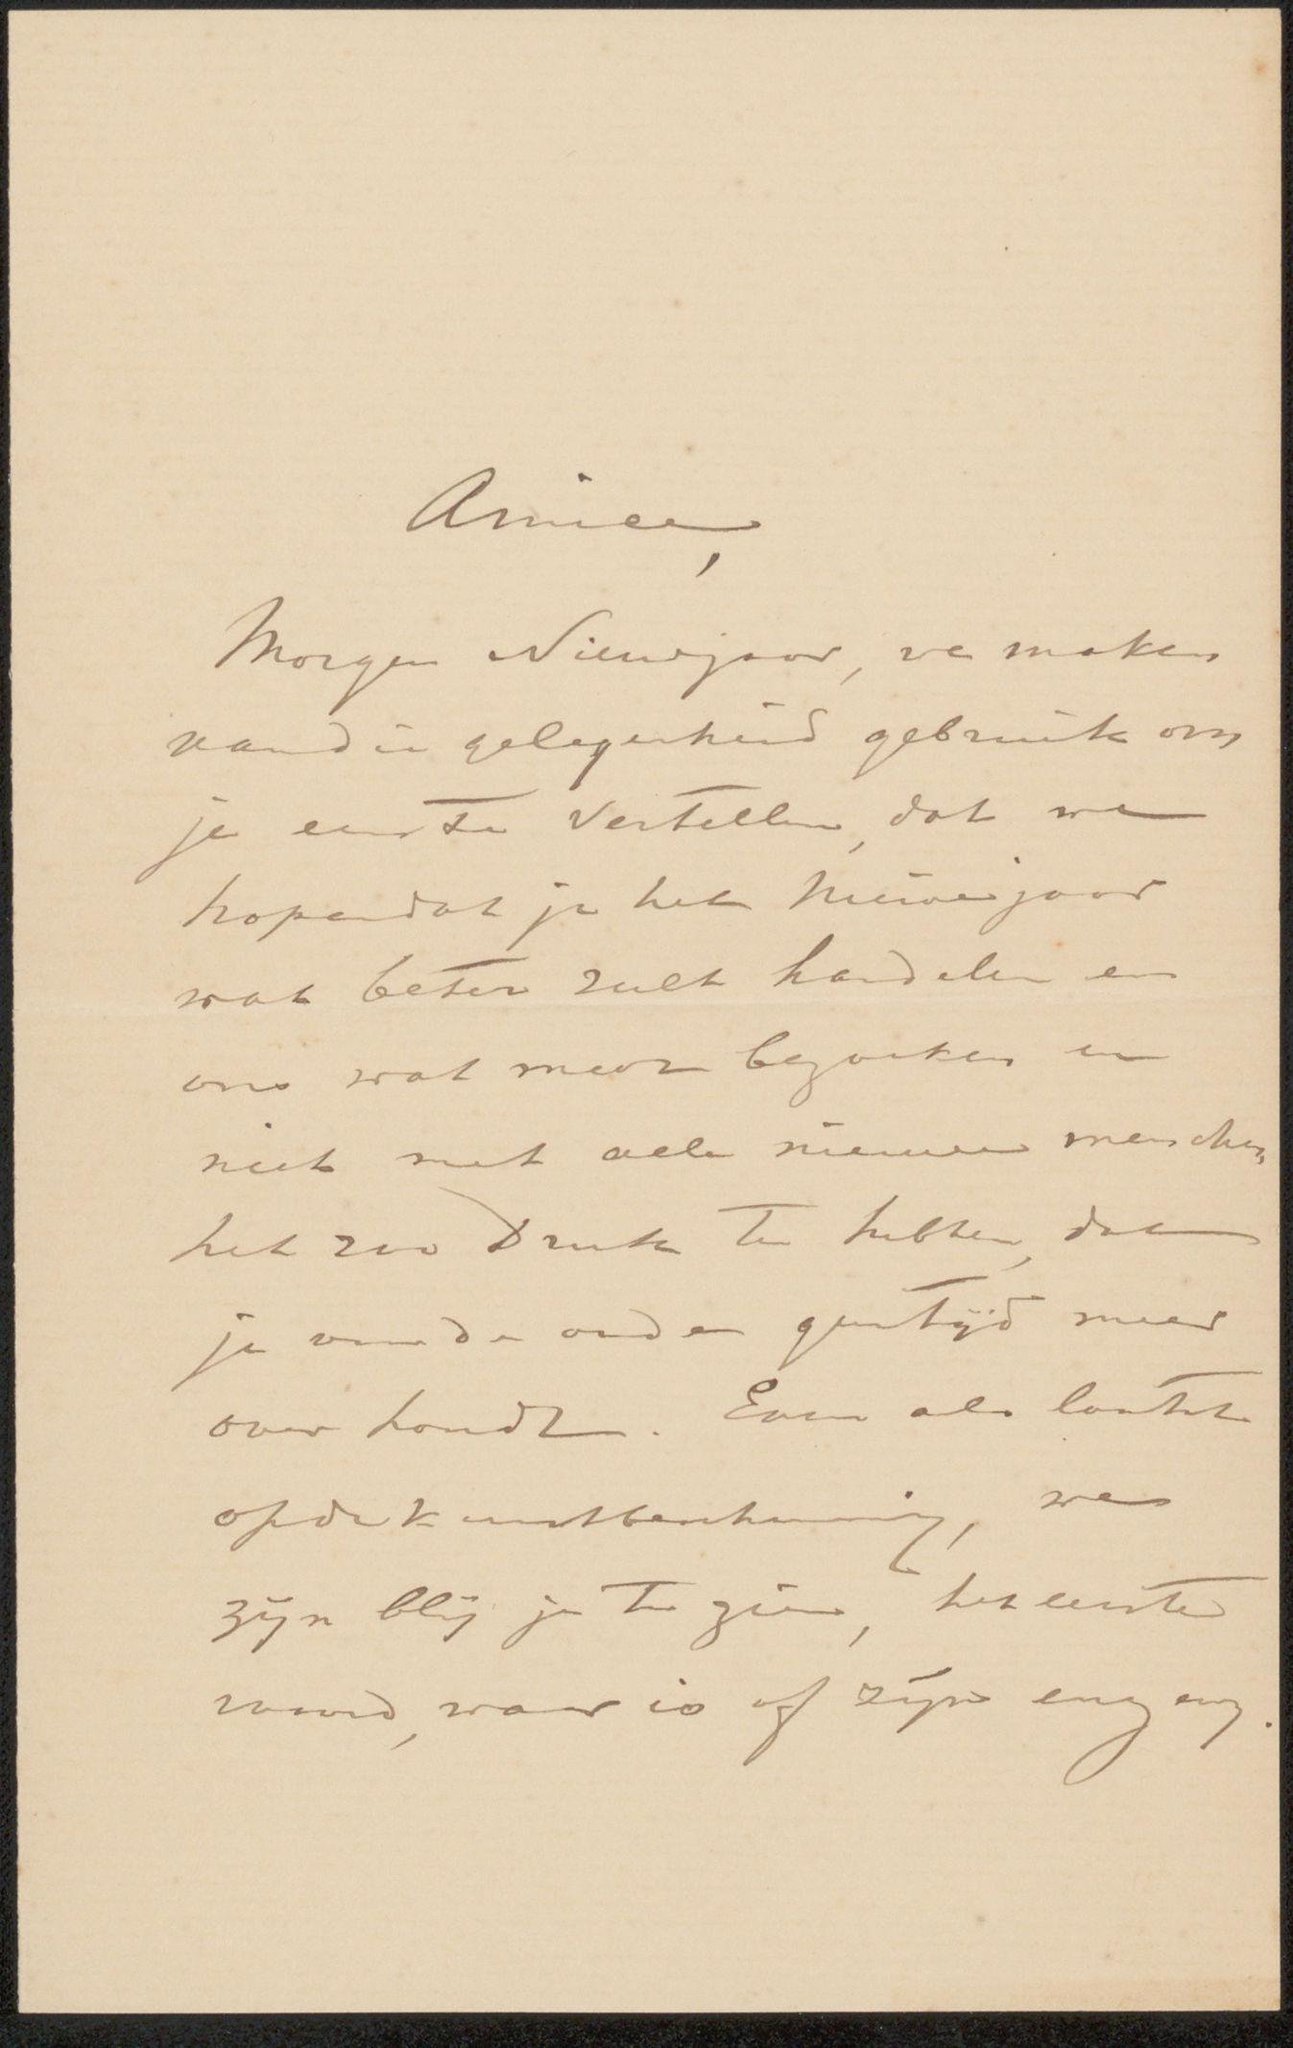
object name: letter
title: Brief aan Philip Zilcken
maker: marinus van der maarel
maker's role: draughtsman, painter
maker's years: 1857-1921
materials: ink, paper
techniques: pen, writing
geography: the hague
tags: painter, draughtsman, philip zilcken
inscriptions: collector's mark: ‘RPK’, watermark